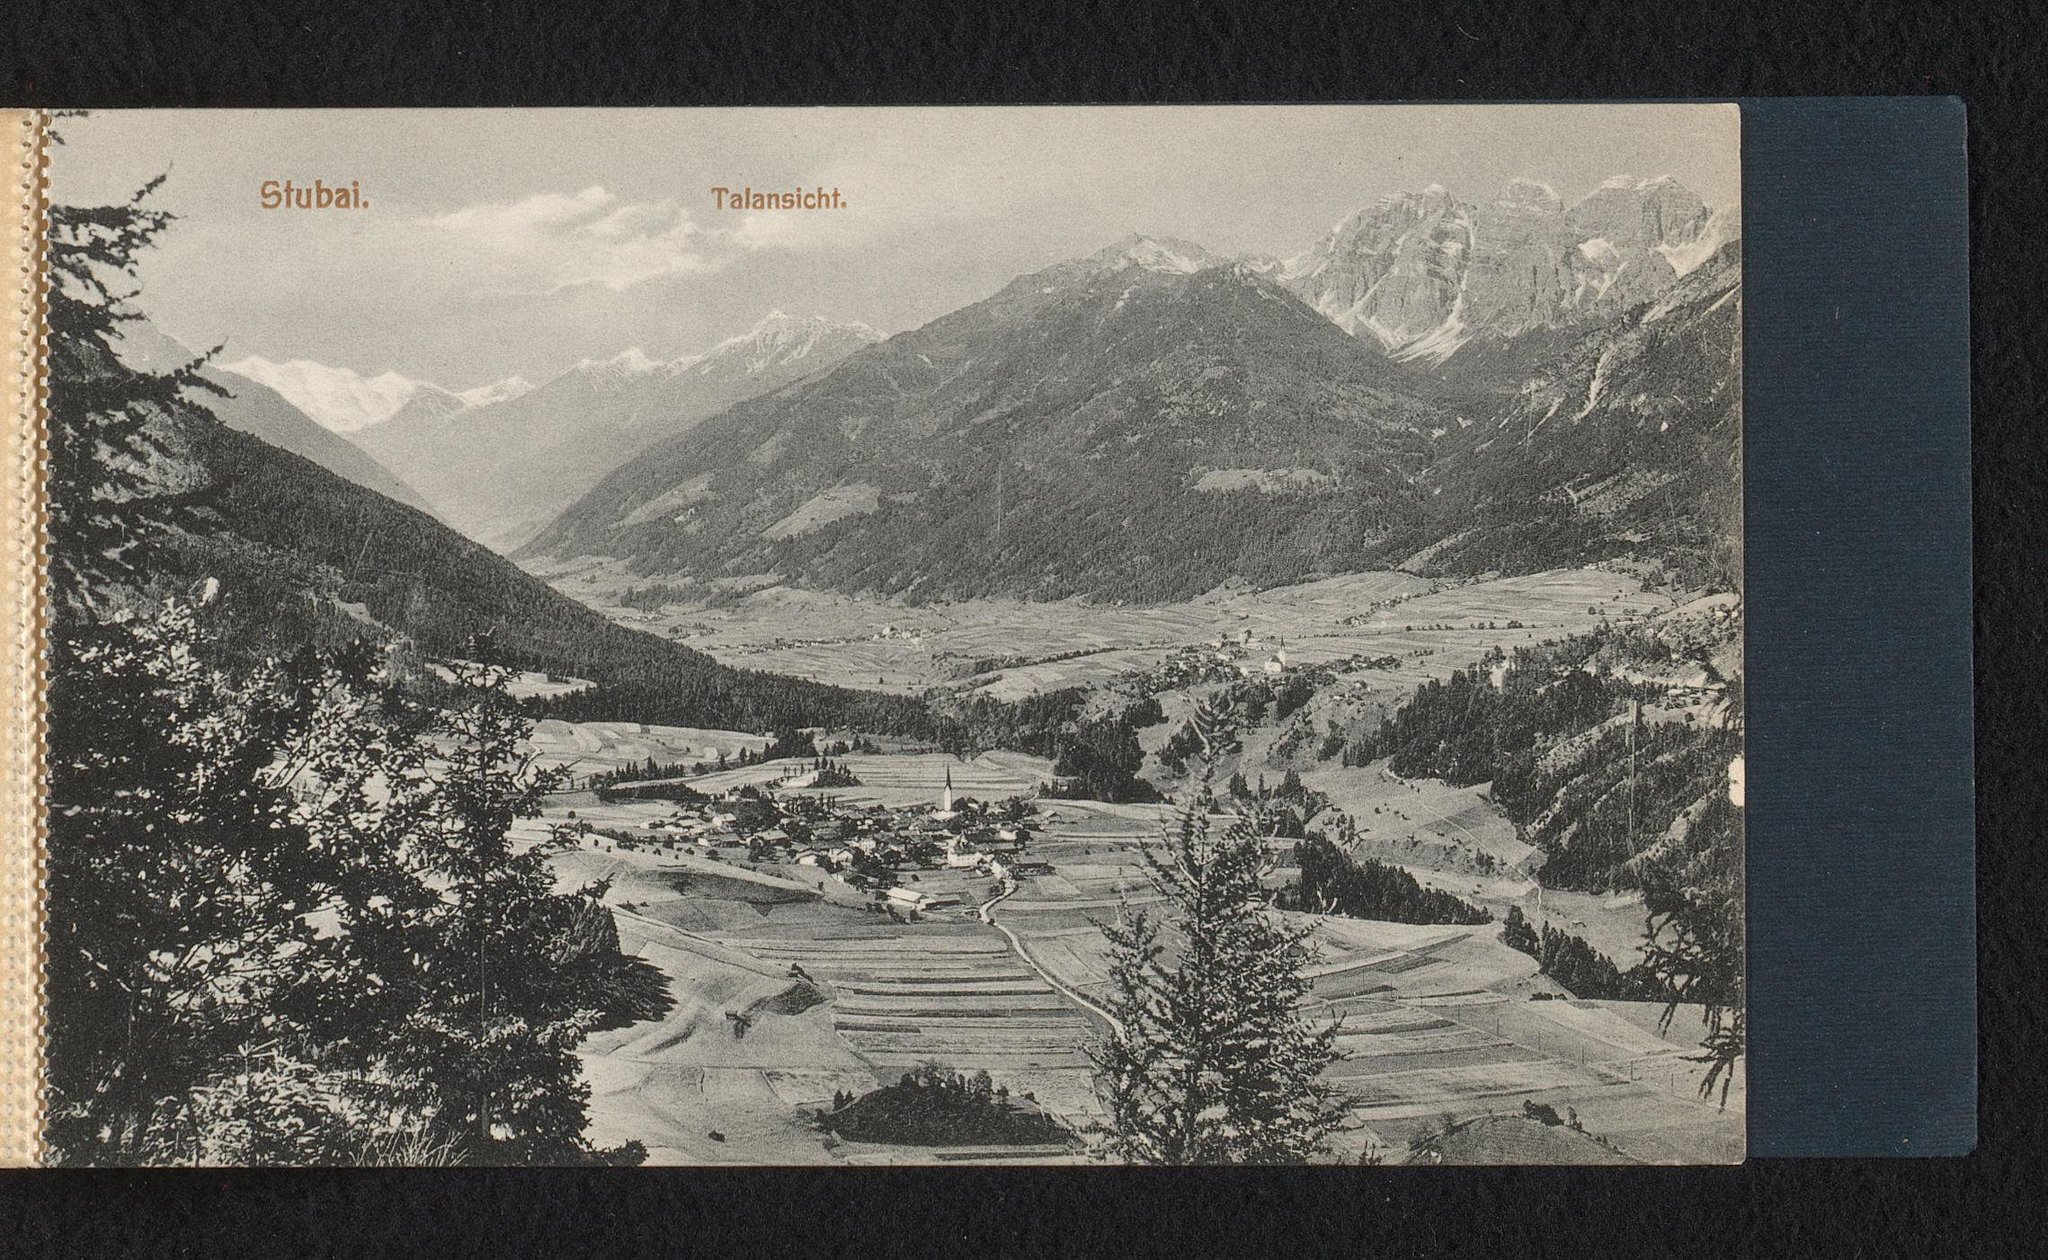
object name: photomechanical print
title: Talansicht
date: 1904-1930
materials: cardboard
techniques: photograph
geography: stubaital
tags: dale, valley, mountains